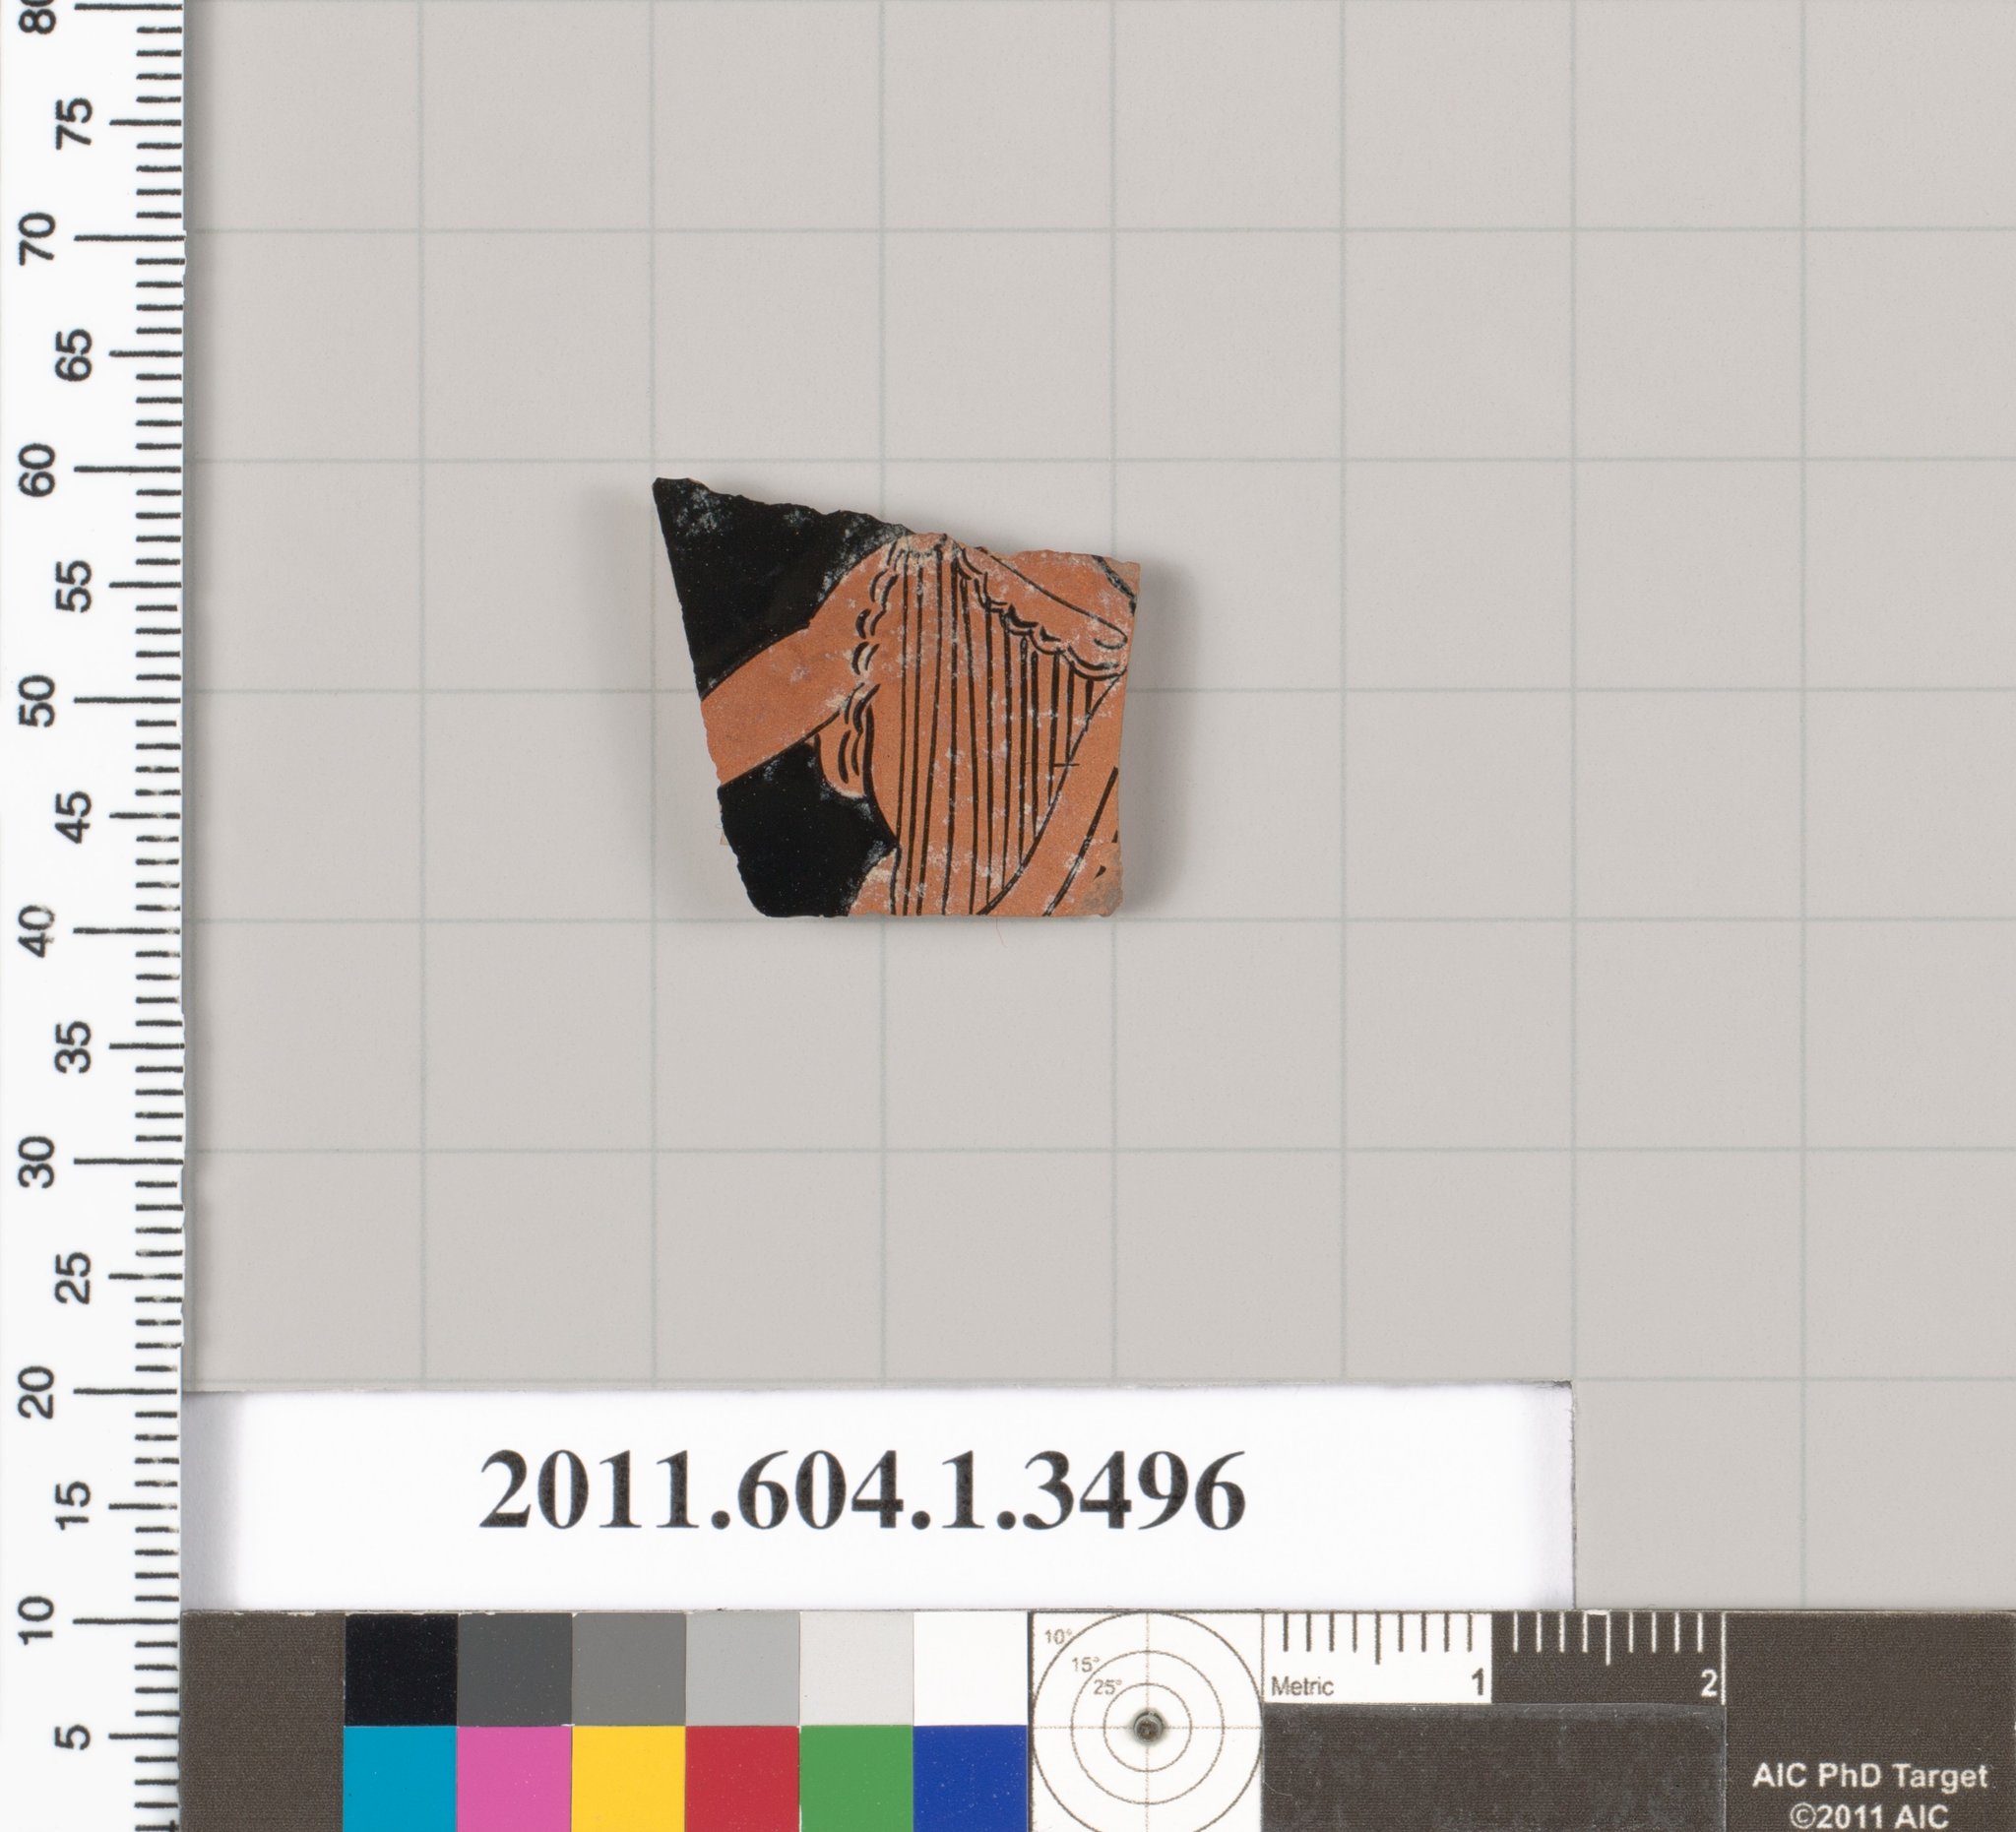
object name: kylix fragment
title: Terracotta fragment of a kylix (drinking cup)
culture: greek, attic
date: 490-480 BCE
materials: terracotta